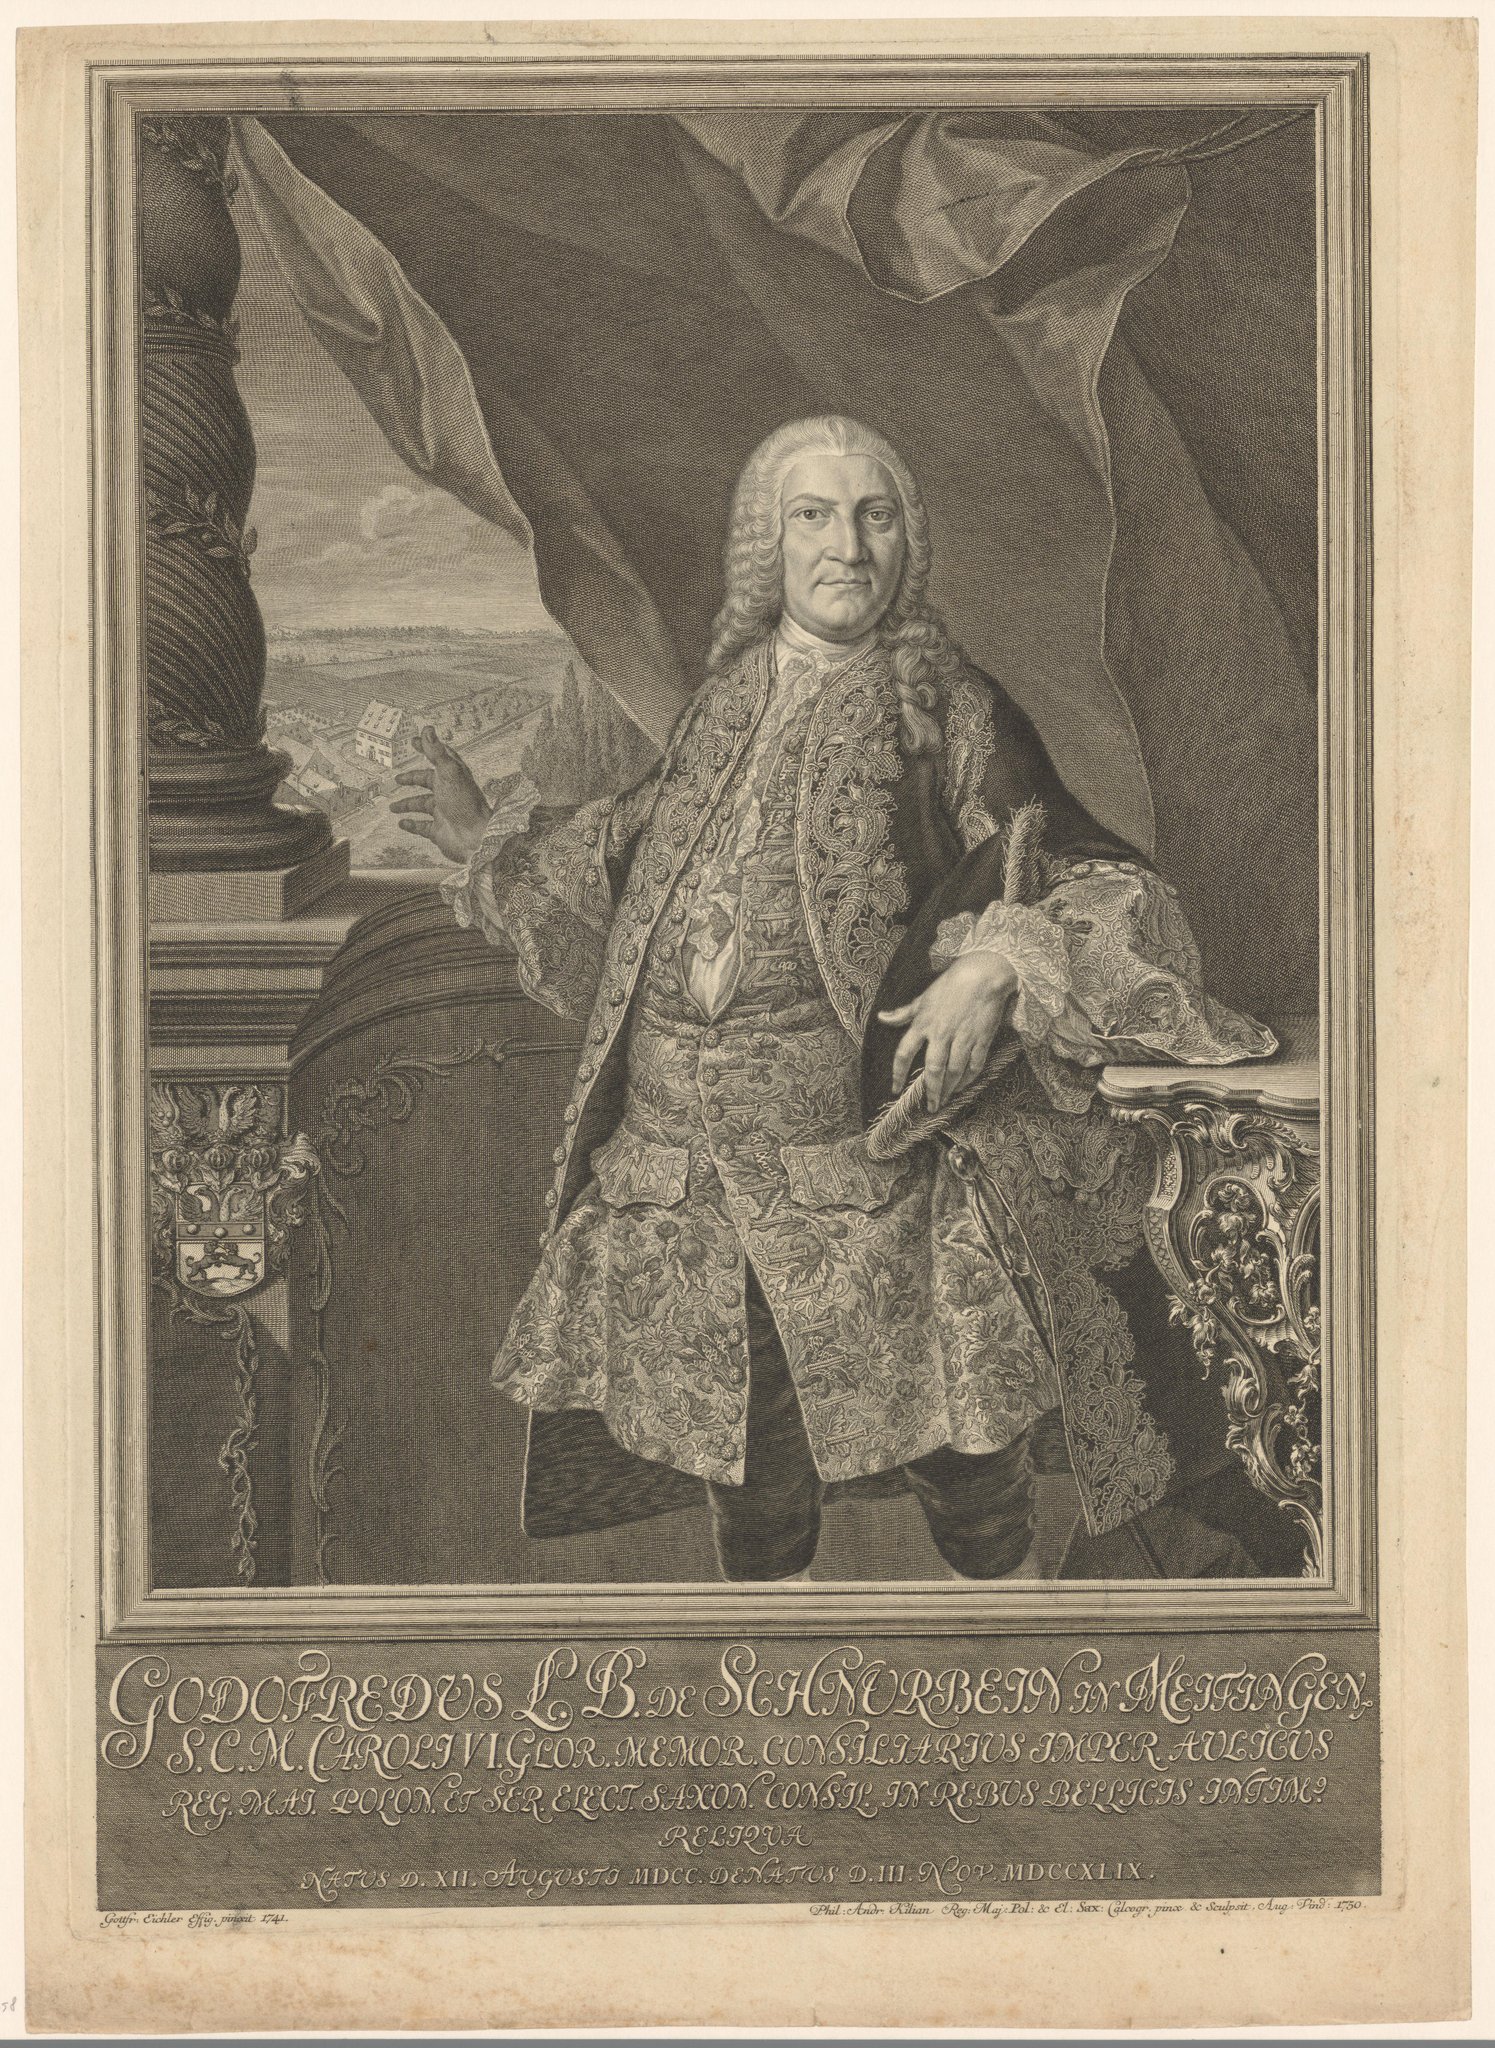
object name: print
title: Portret van Gottfried Schnurbein von und zu Meitingen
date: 1750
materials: paper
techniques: engraving, etching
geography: augsburg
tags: historical persons, ambassador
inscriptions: collector's mark: Lugt 2228